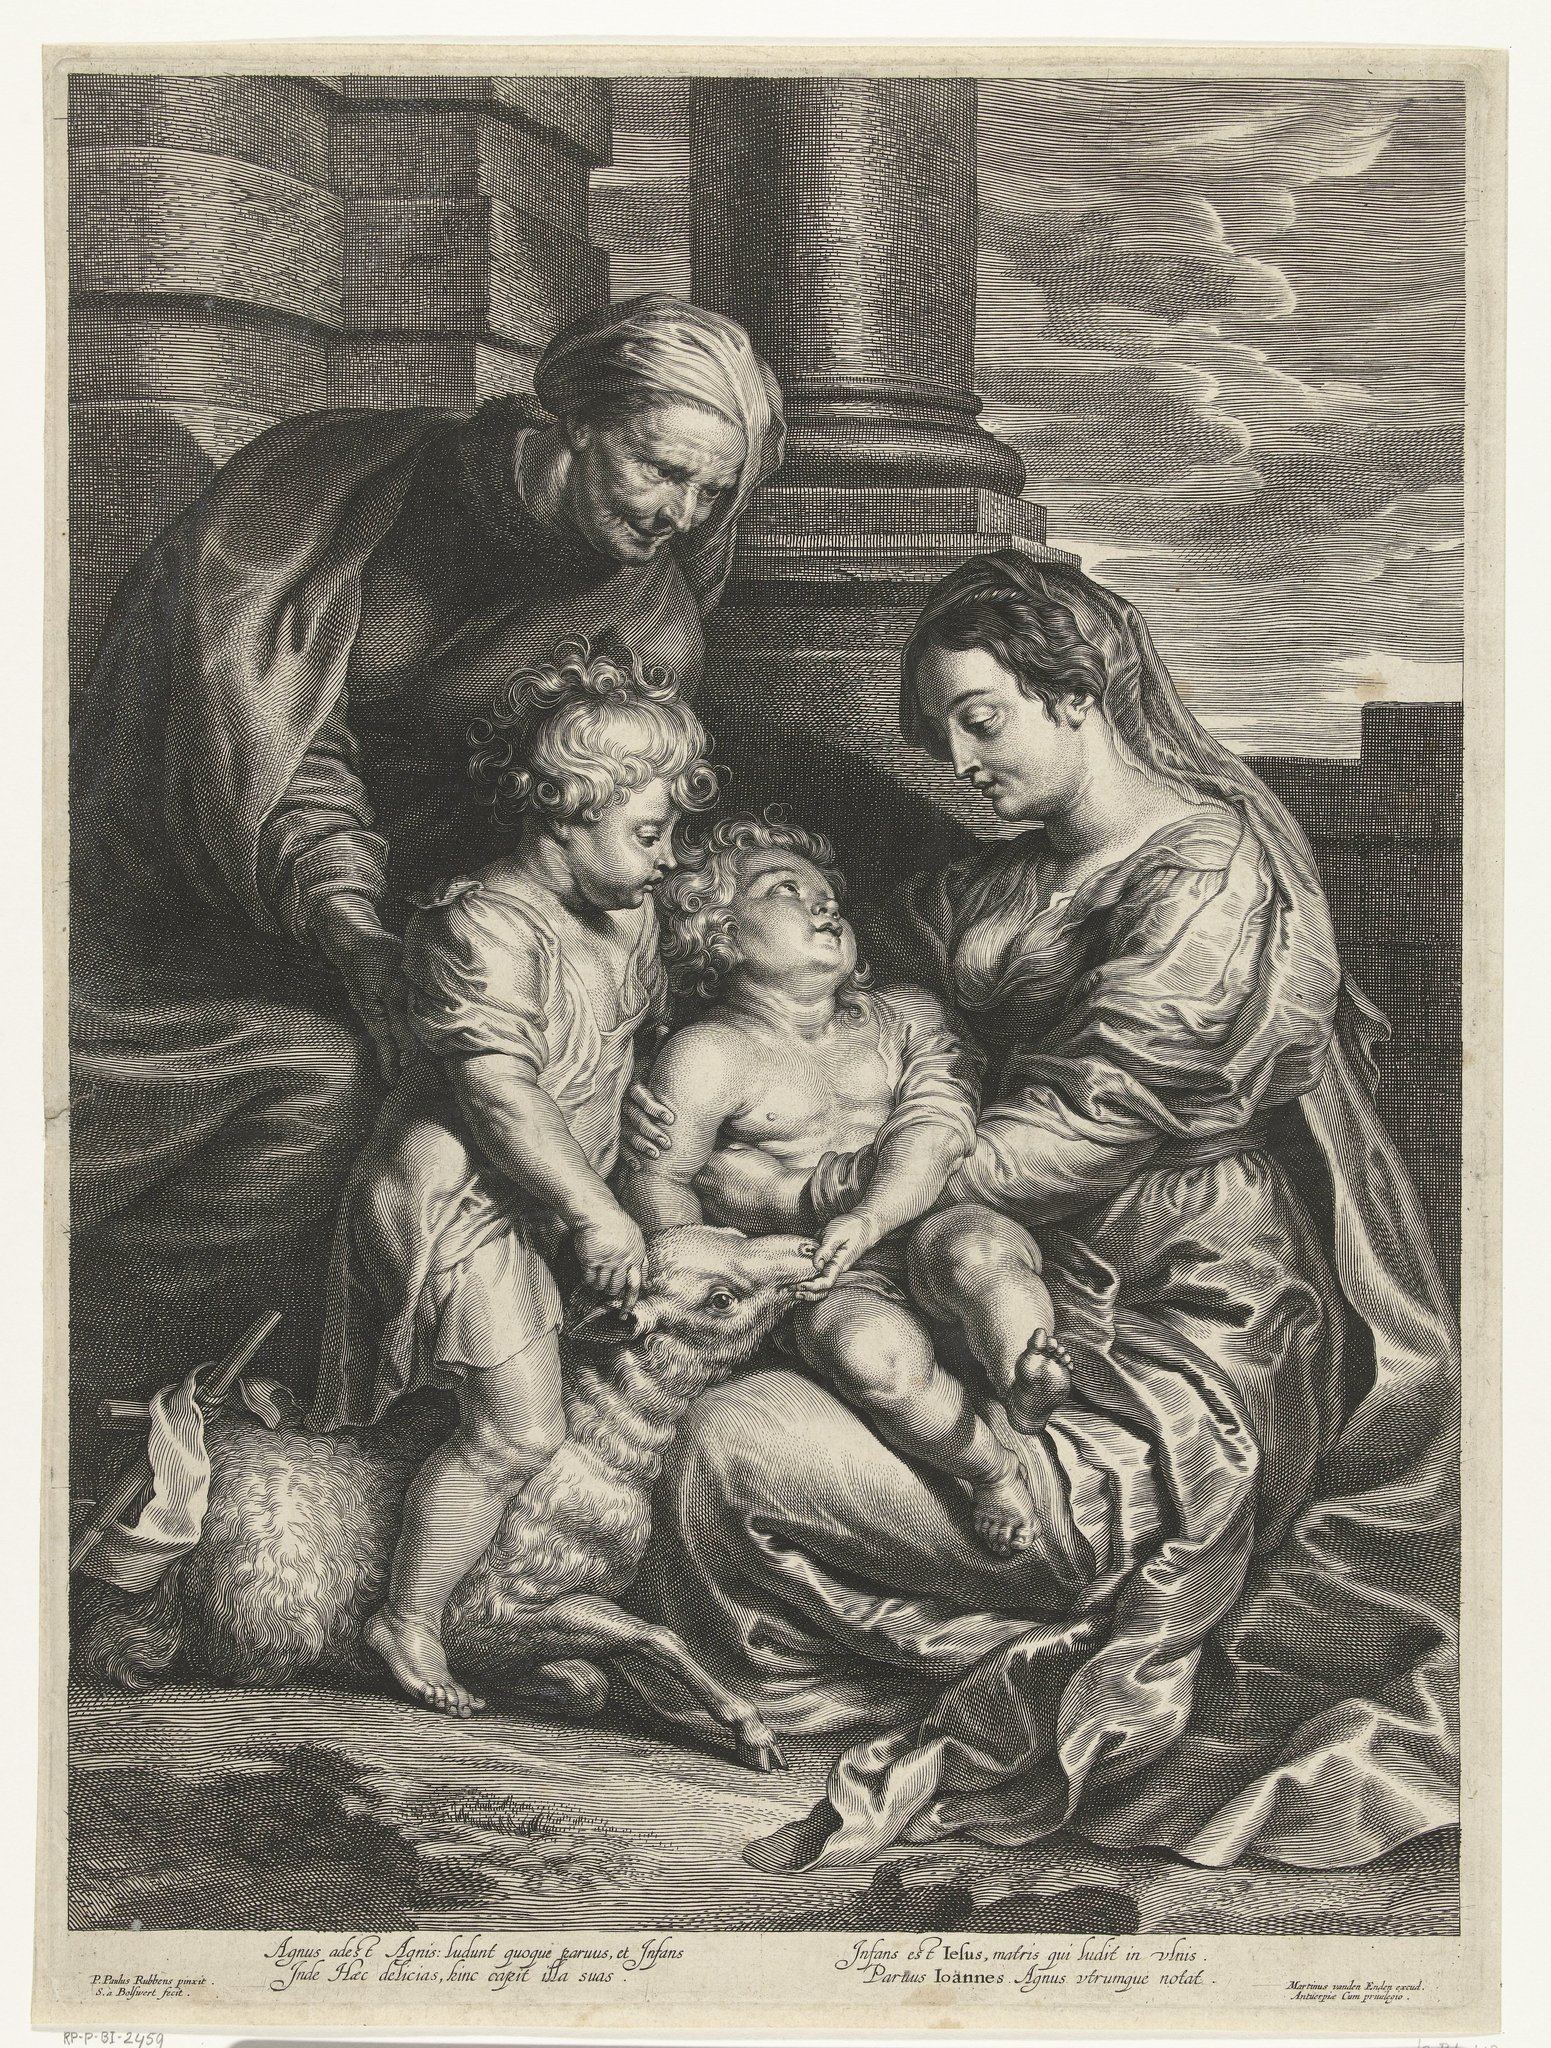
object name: print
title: Maria met kind en heilige Anna en heilige Johannes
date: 1596-1659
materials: paper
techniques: engraving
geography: antwerp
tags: the apostle john the evangelist; possible attributes: book, cauldron, chalice with snake, eagle, palm, scroll, madonna accompanied by saint(s), anna, mother of mary; possible attributes: book, christ-child, lily, virgin mary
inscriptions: collector's mark: Lugt 240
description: Maria zit op de grond met Christuskind op schoot en de heilige Anna staat met de heilige Johannes als kind en een lam bij hen. Onder de voorstelling staat een Latijns vers.